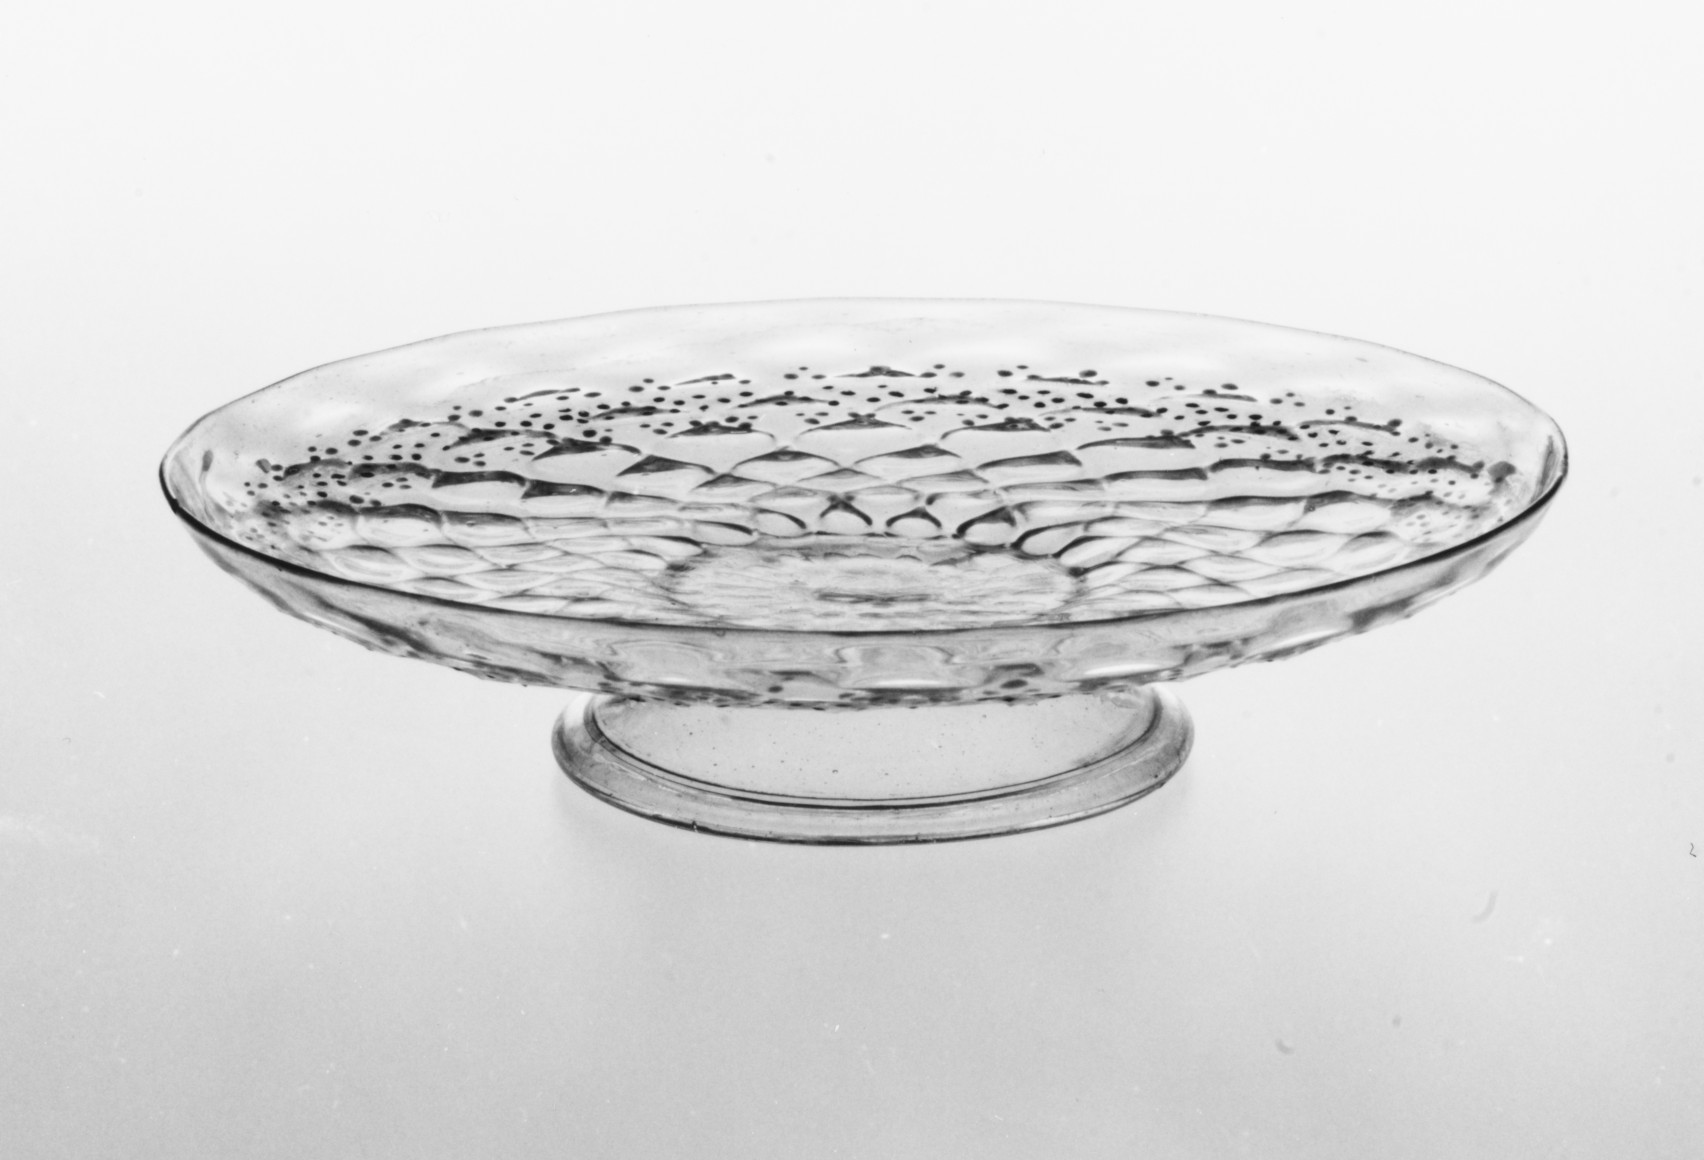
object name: tazza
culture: italian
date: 1500-1525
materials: gilt, glass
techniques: glassblowing, enamel, molding